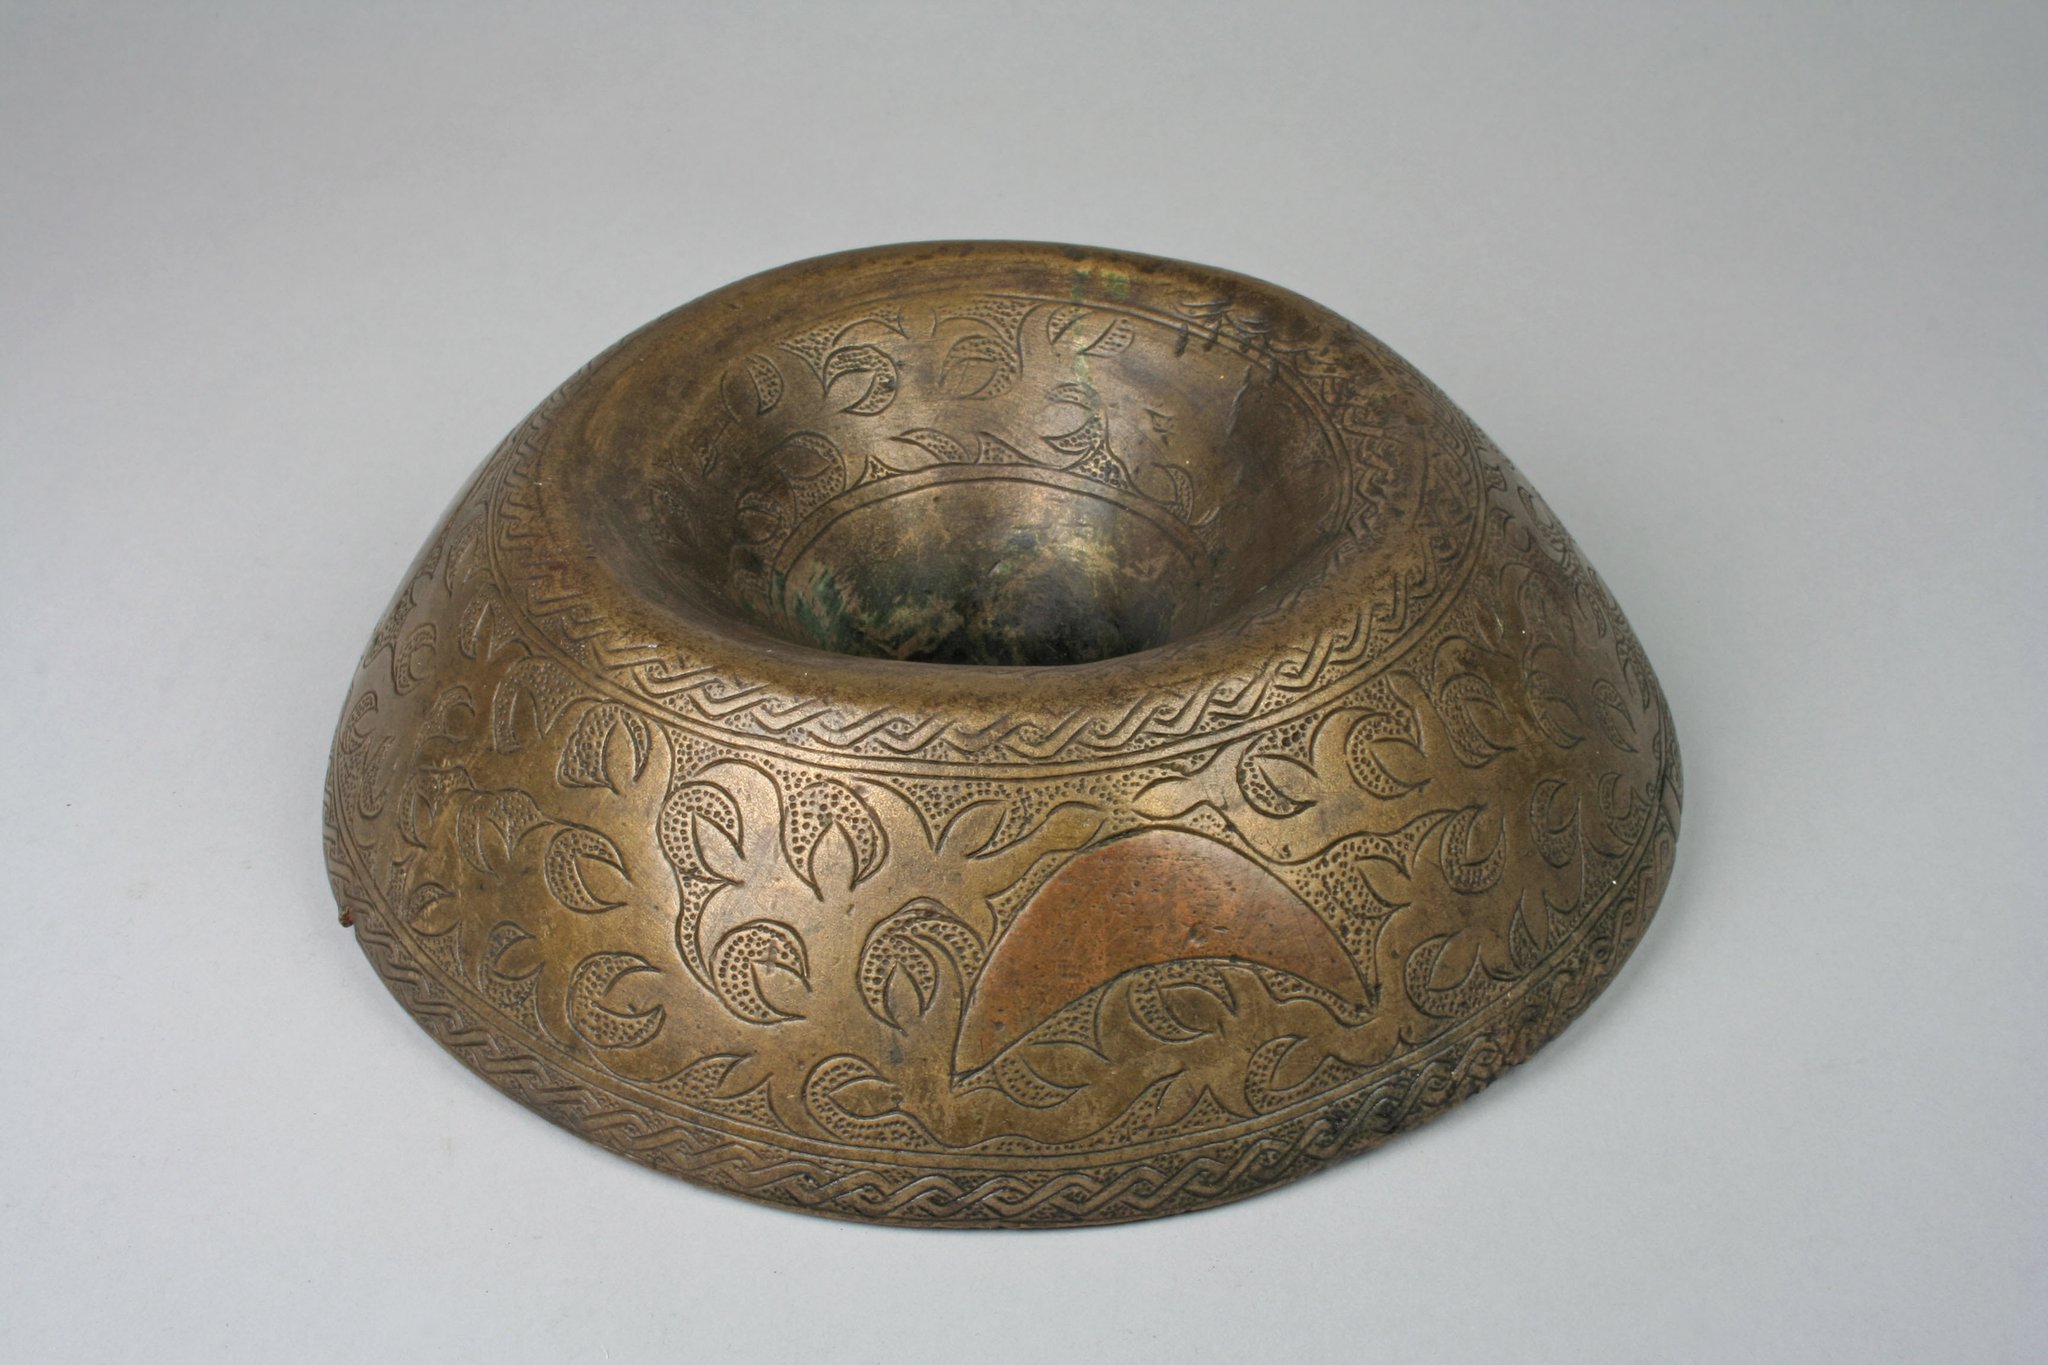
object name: vessel base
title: Base of Lidded Vessel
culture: edo period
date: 1501-1900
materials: brass, copper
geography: nigeria